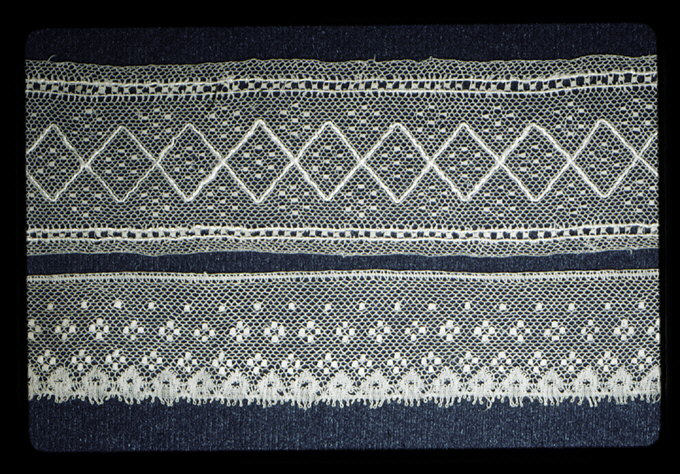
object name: fragment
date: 1801-1900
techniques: lace